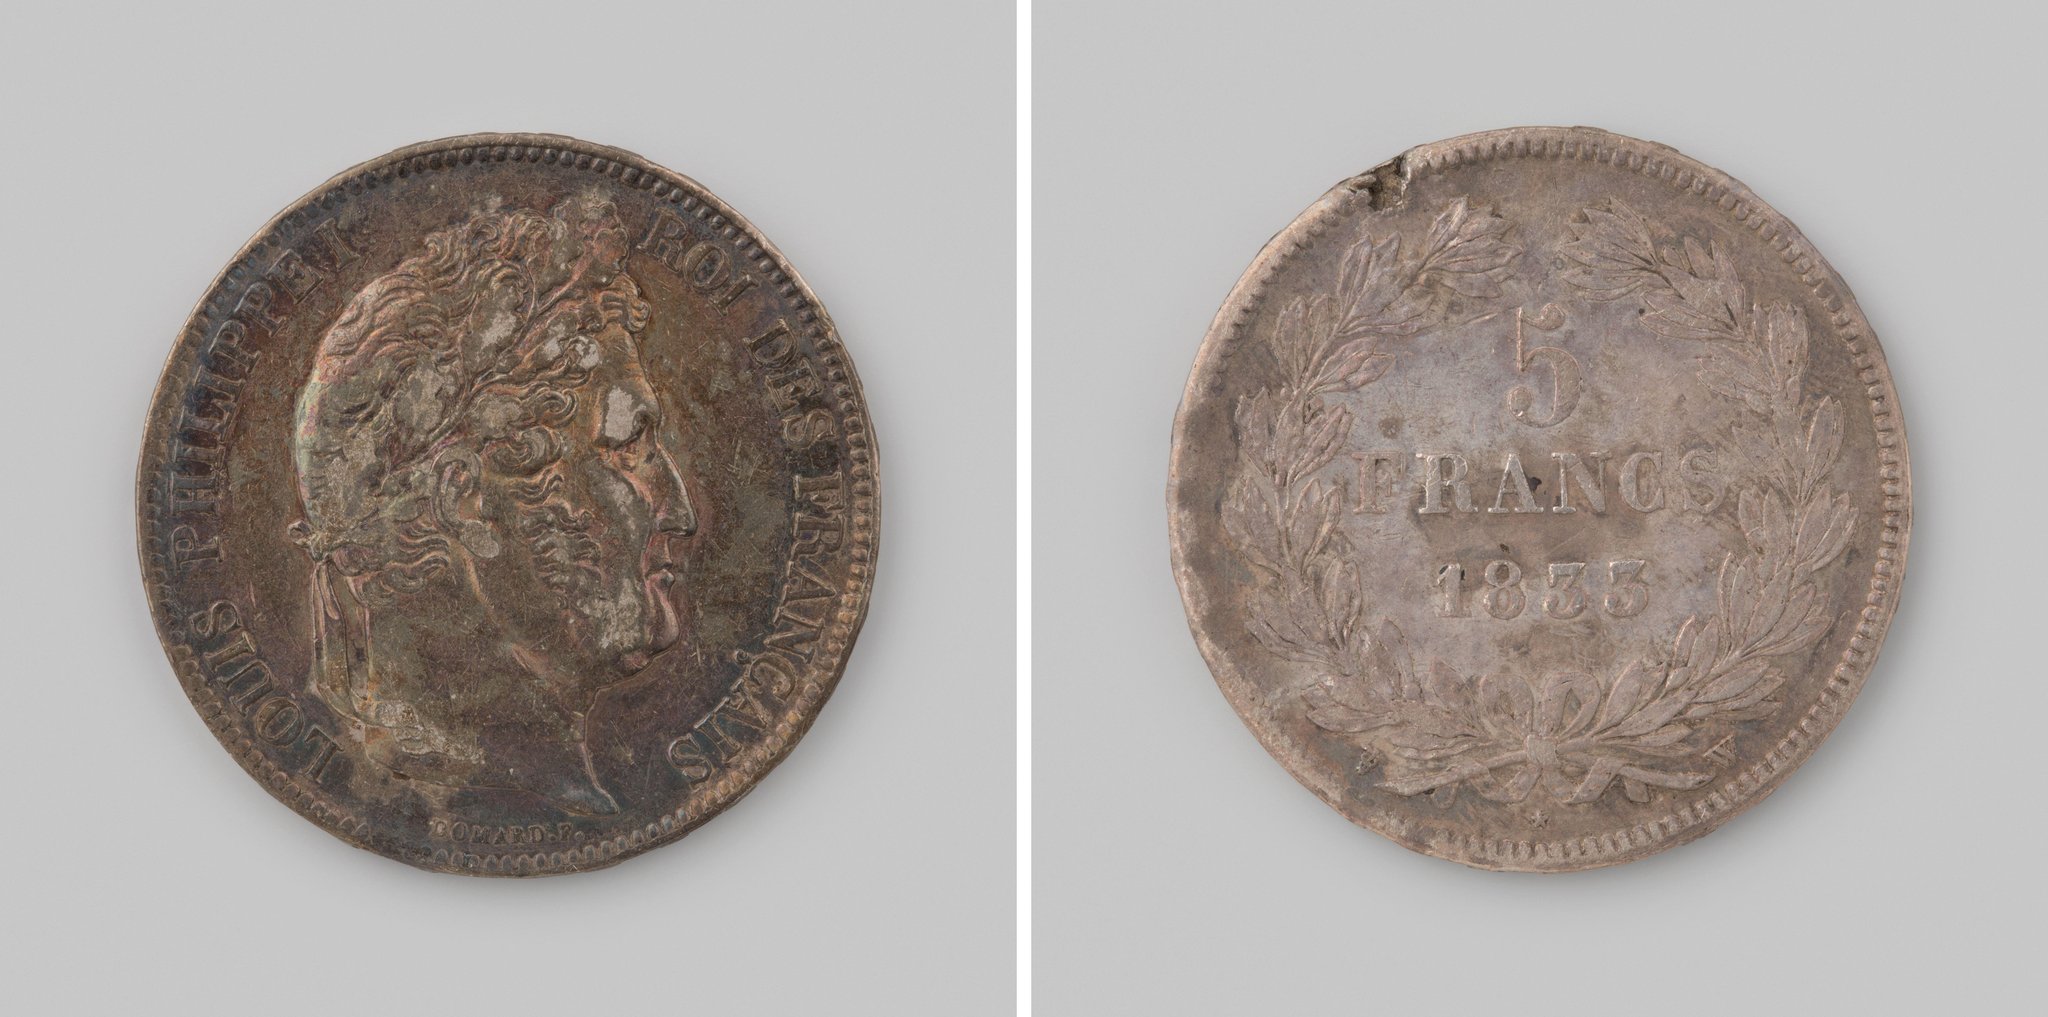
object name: coin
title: 5 francs uit het koninkrijk Frankrijk van Louis Philippe I, 1833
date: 1833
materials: silver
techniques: striking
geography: lille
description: Zilveren munt. Voorzijde: hoofd van de koning met krans van eikenbladeren naar rechts. Keerzijde: binnen twee samengebonden lauriertakken waarde-aanduiding in twee regels, waaronder jaartal. Rechts onderaan letters VV [=Lille]. Opliggend randschrift.